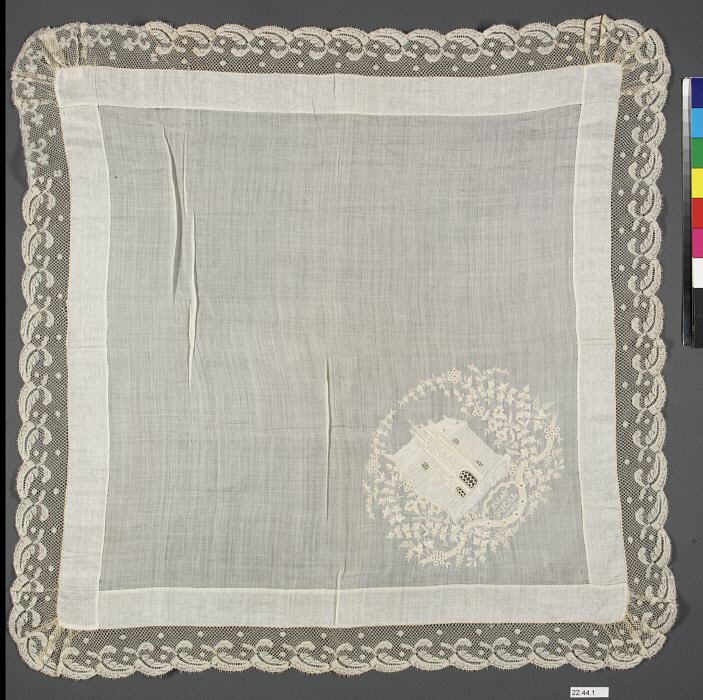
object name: handkerchief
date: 1801-1900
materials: linen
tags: houses